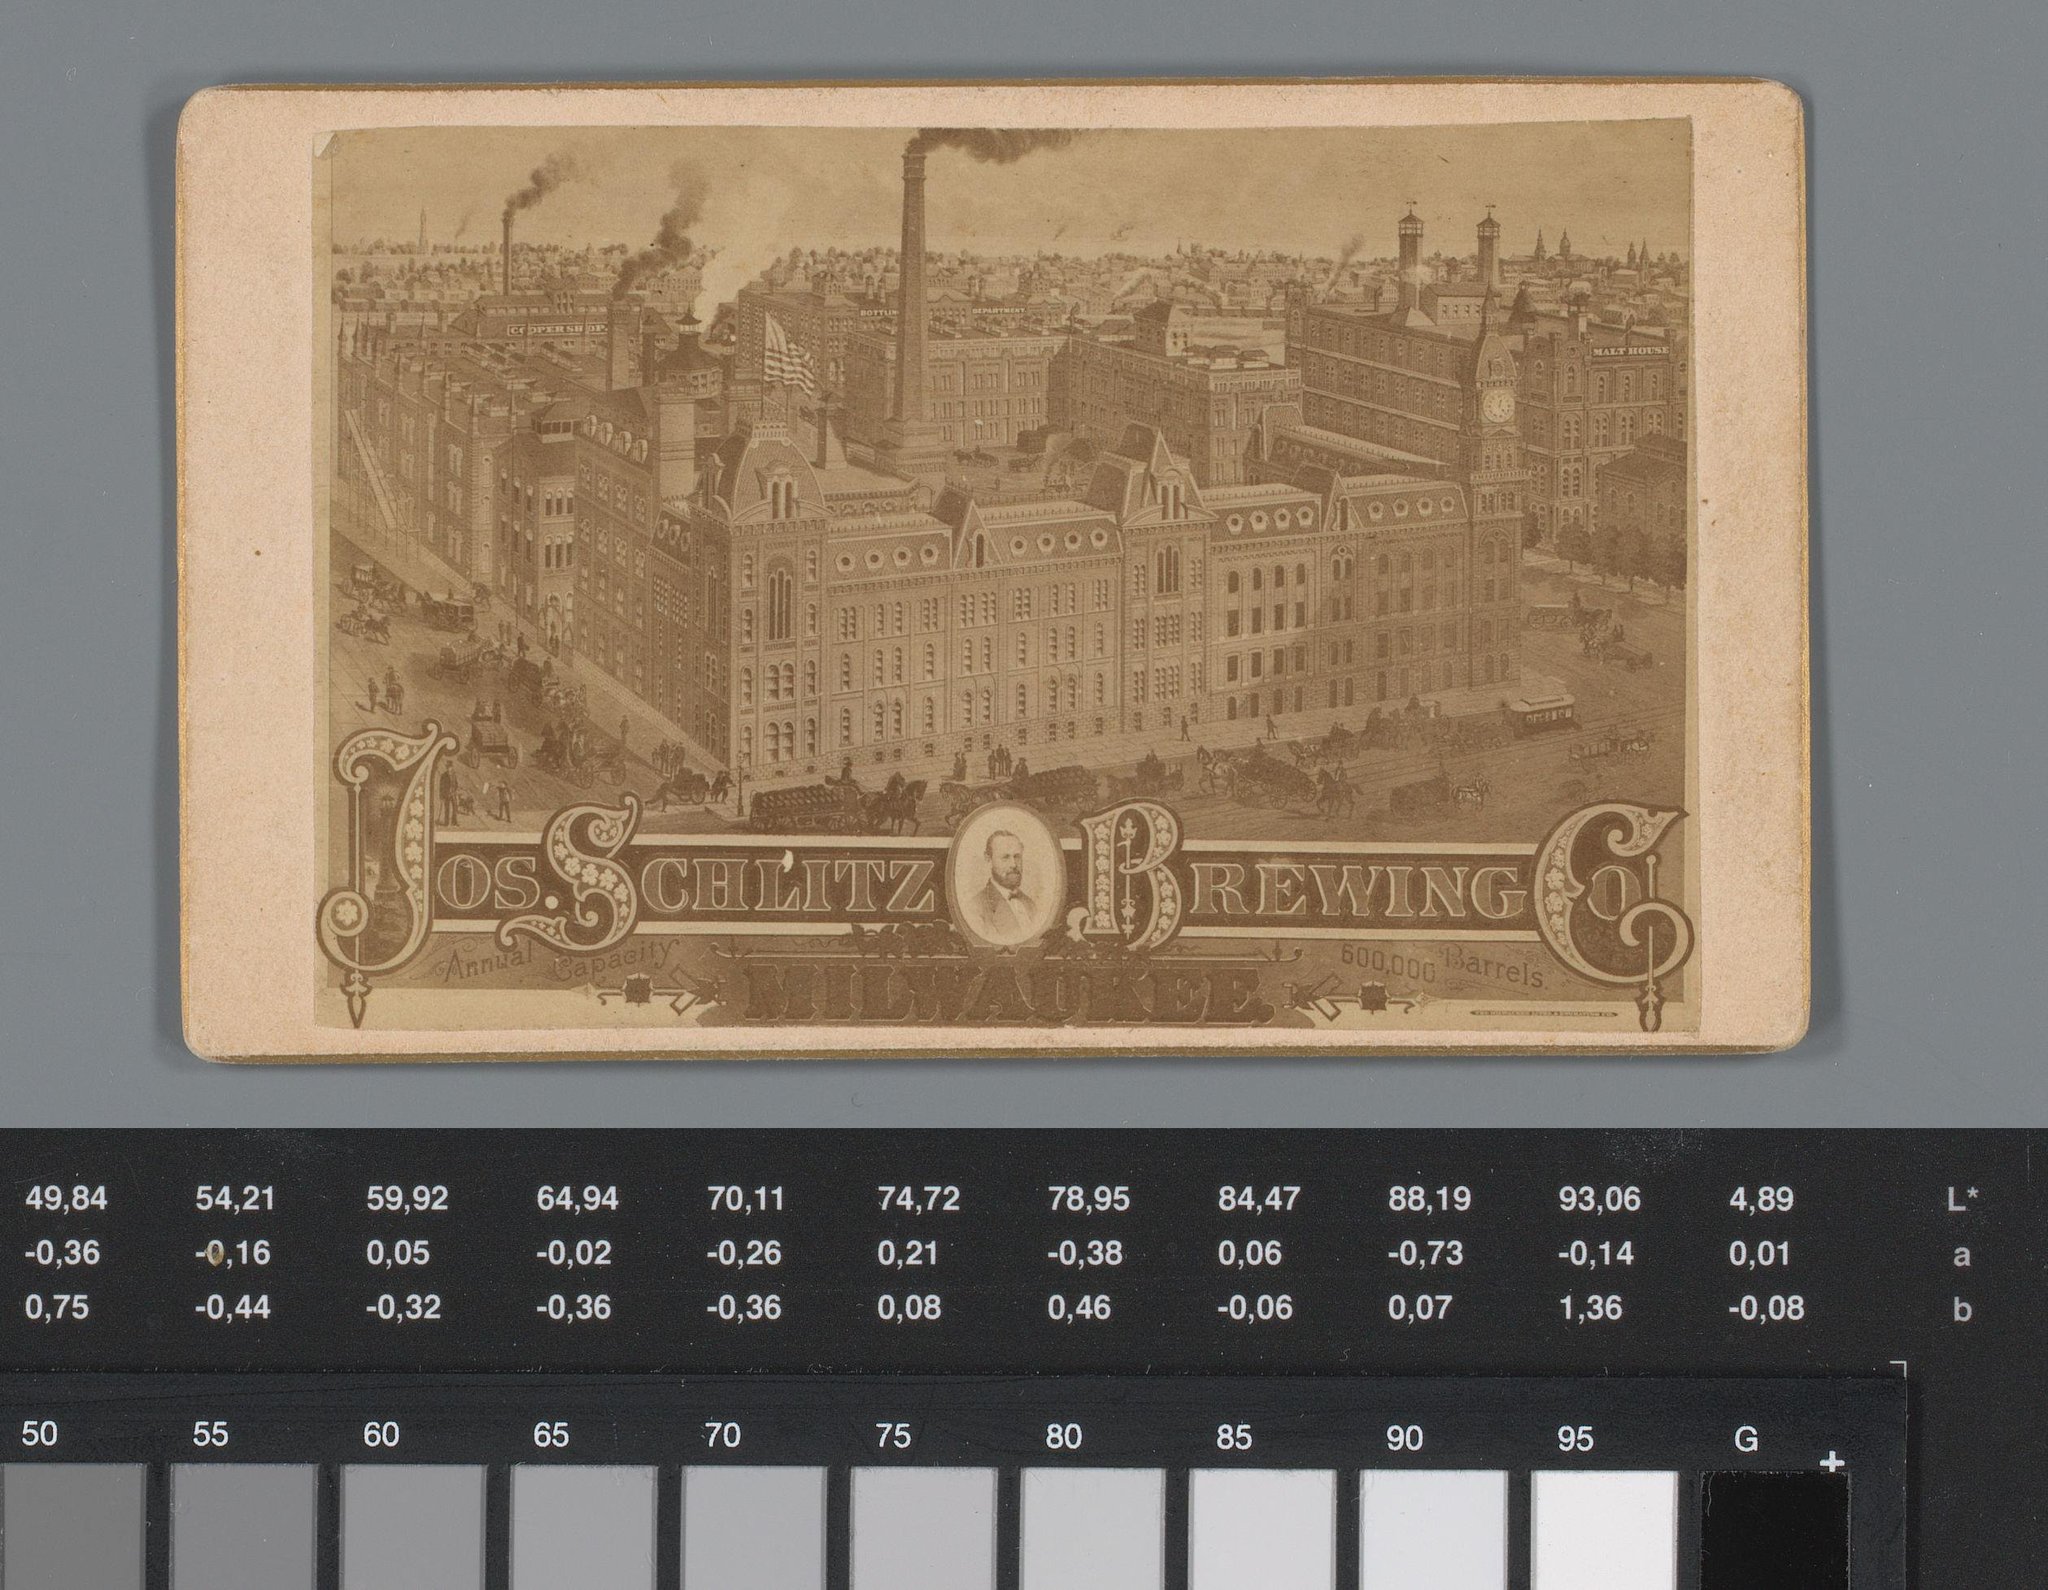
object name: carte de visite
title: Reclame voor Joseph Schlitz Brewing Company te Milwaukee, met foto van gezicht op de brouwerij aldaar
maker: Anonymous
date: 1850-1915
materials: cardboard, photographic support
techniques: albumen print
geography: milwaukee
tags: advertising, brewer (+ place ~ crafts, industries, agriculture), exterior of industrial structures, factories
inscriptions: inscription: ‘(...)/ 345,554 BARRELS /(...)’